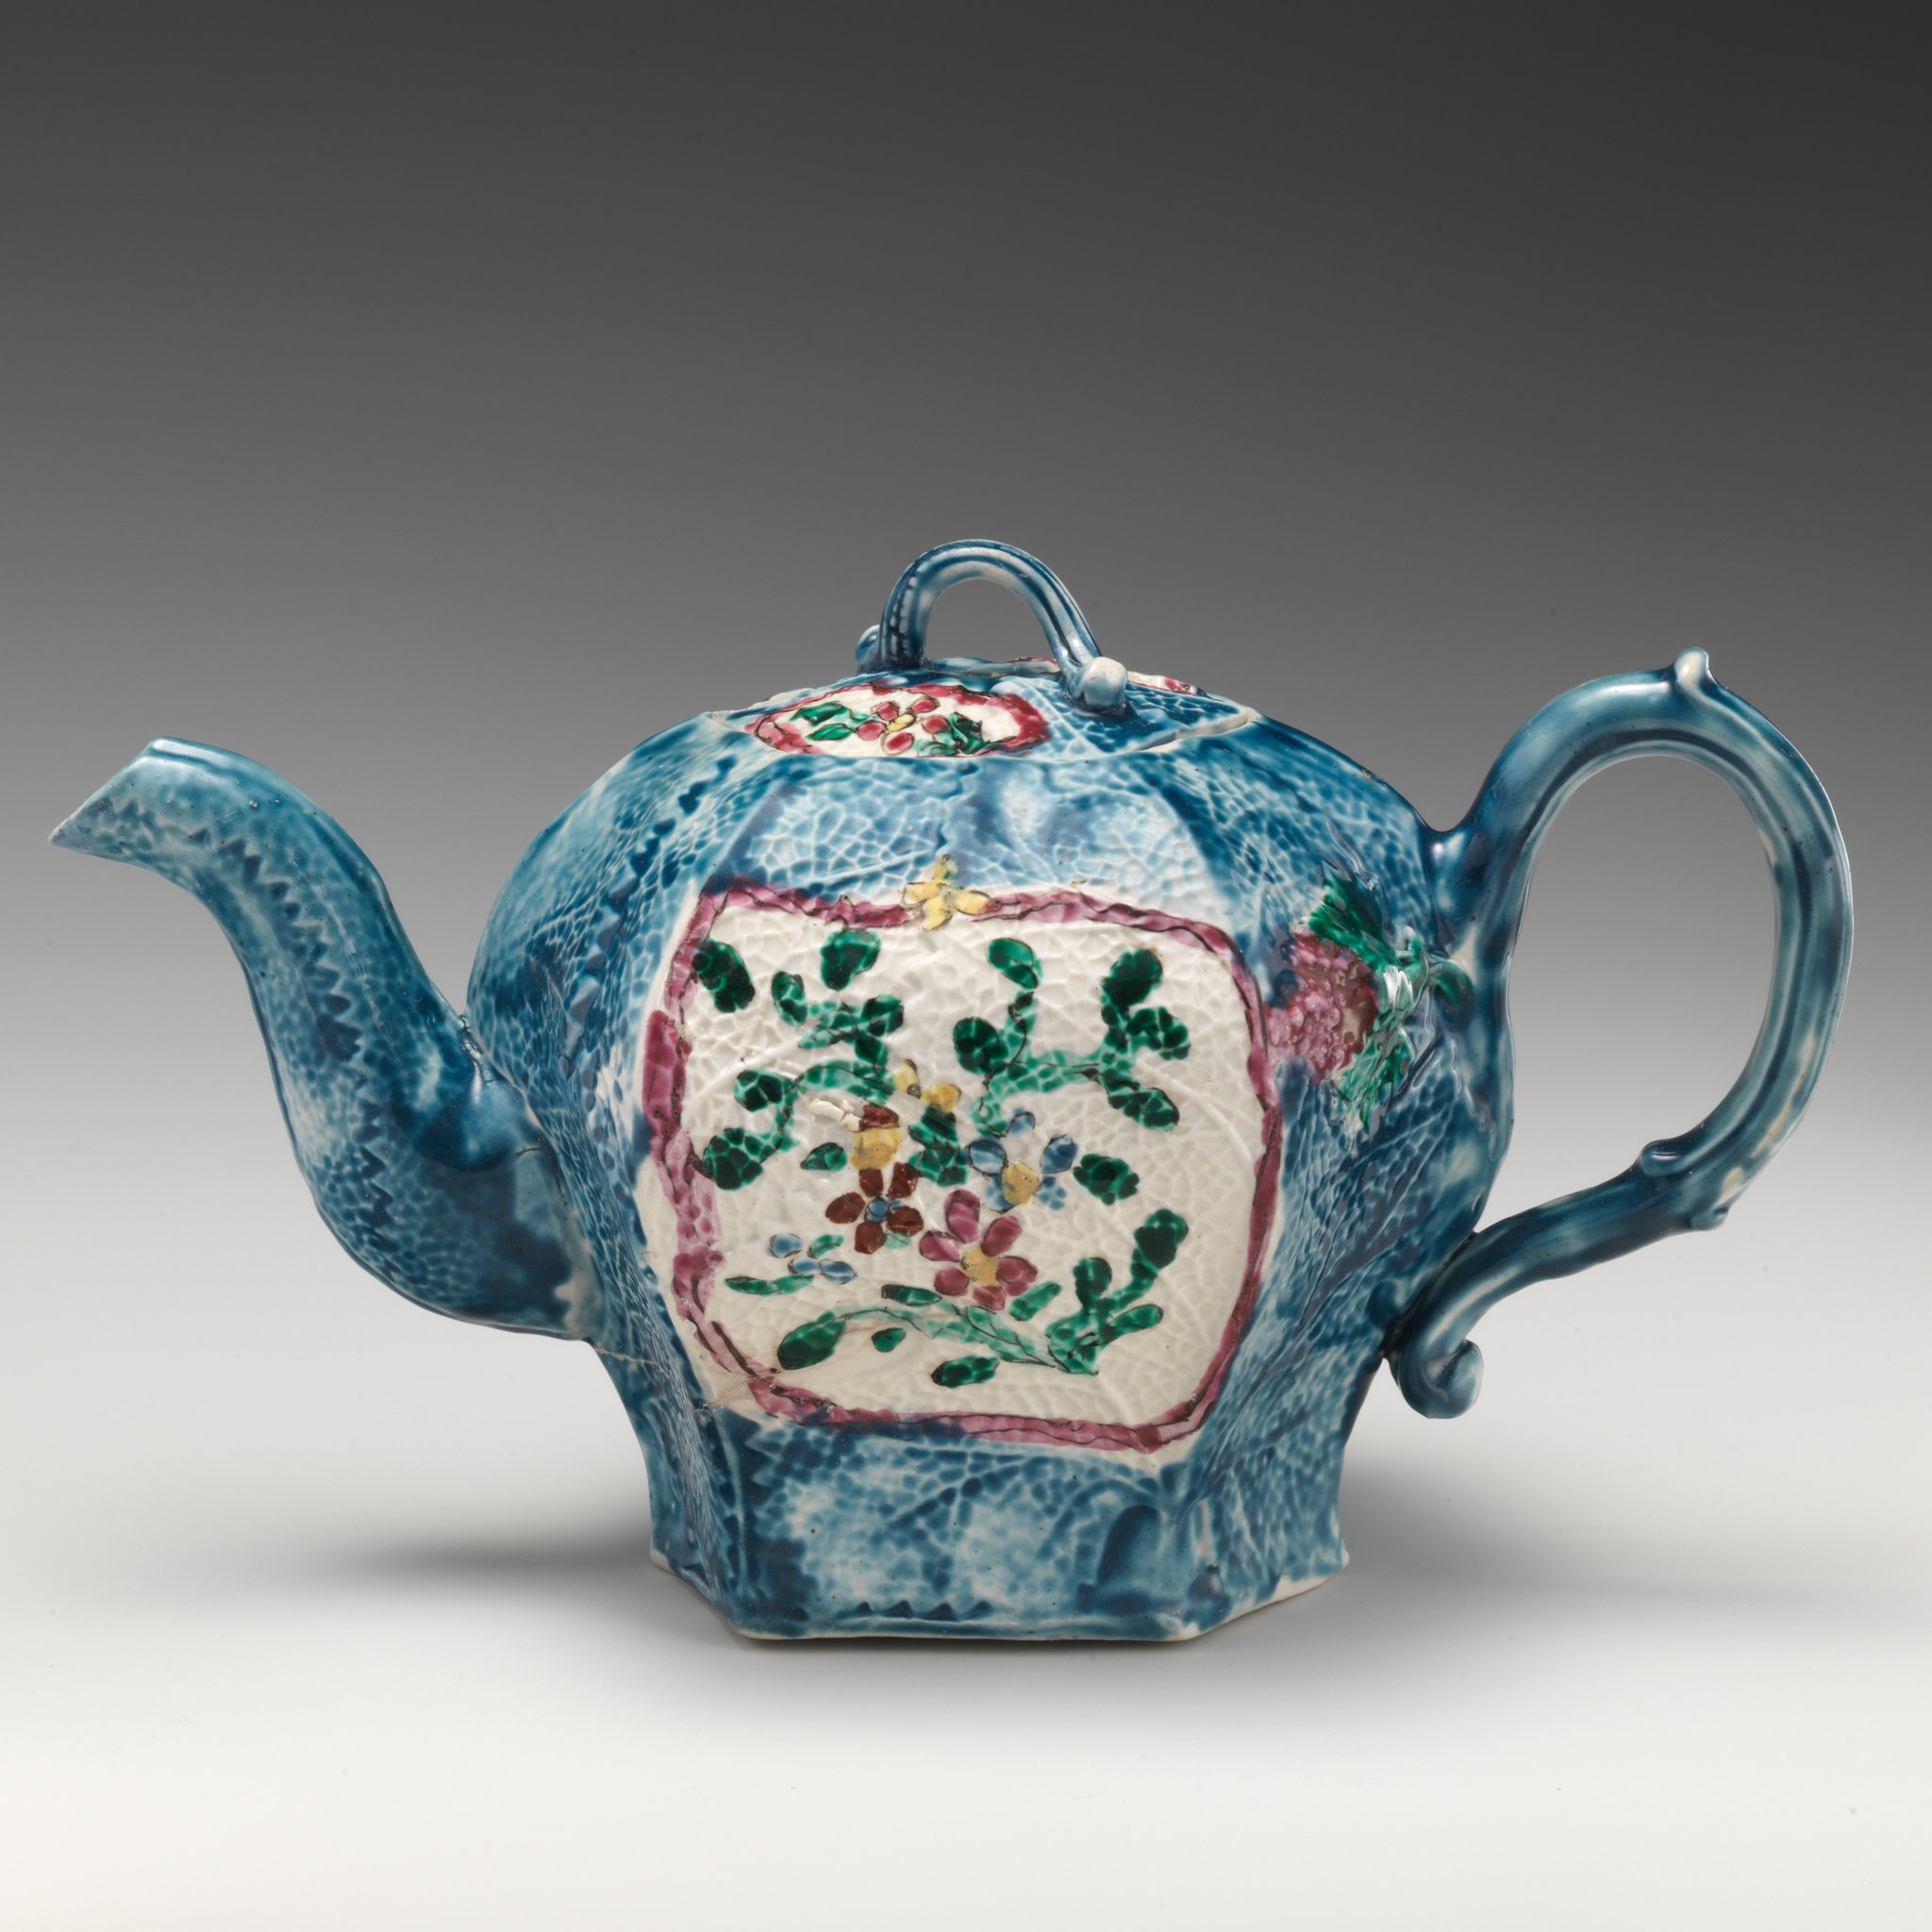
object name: teapot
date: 1760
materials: enamel, stoneware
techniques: salt glaze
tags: flowers